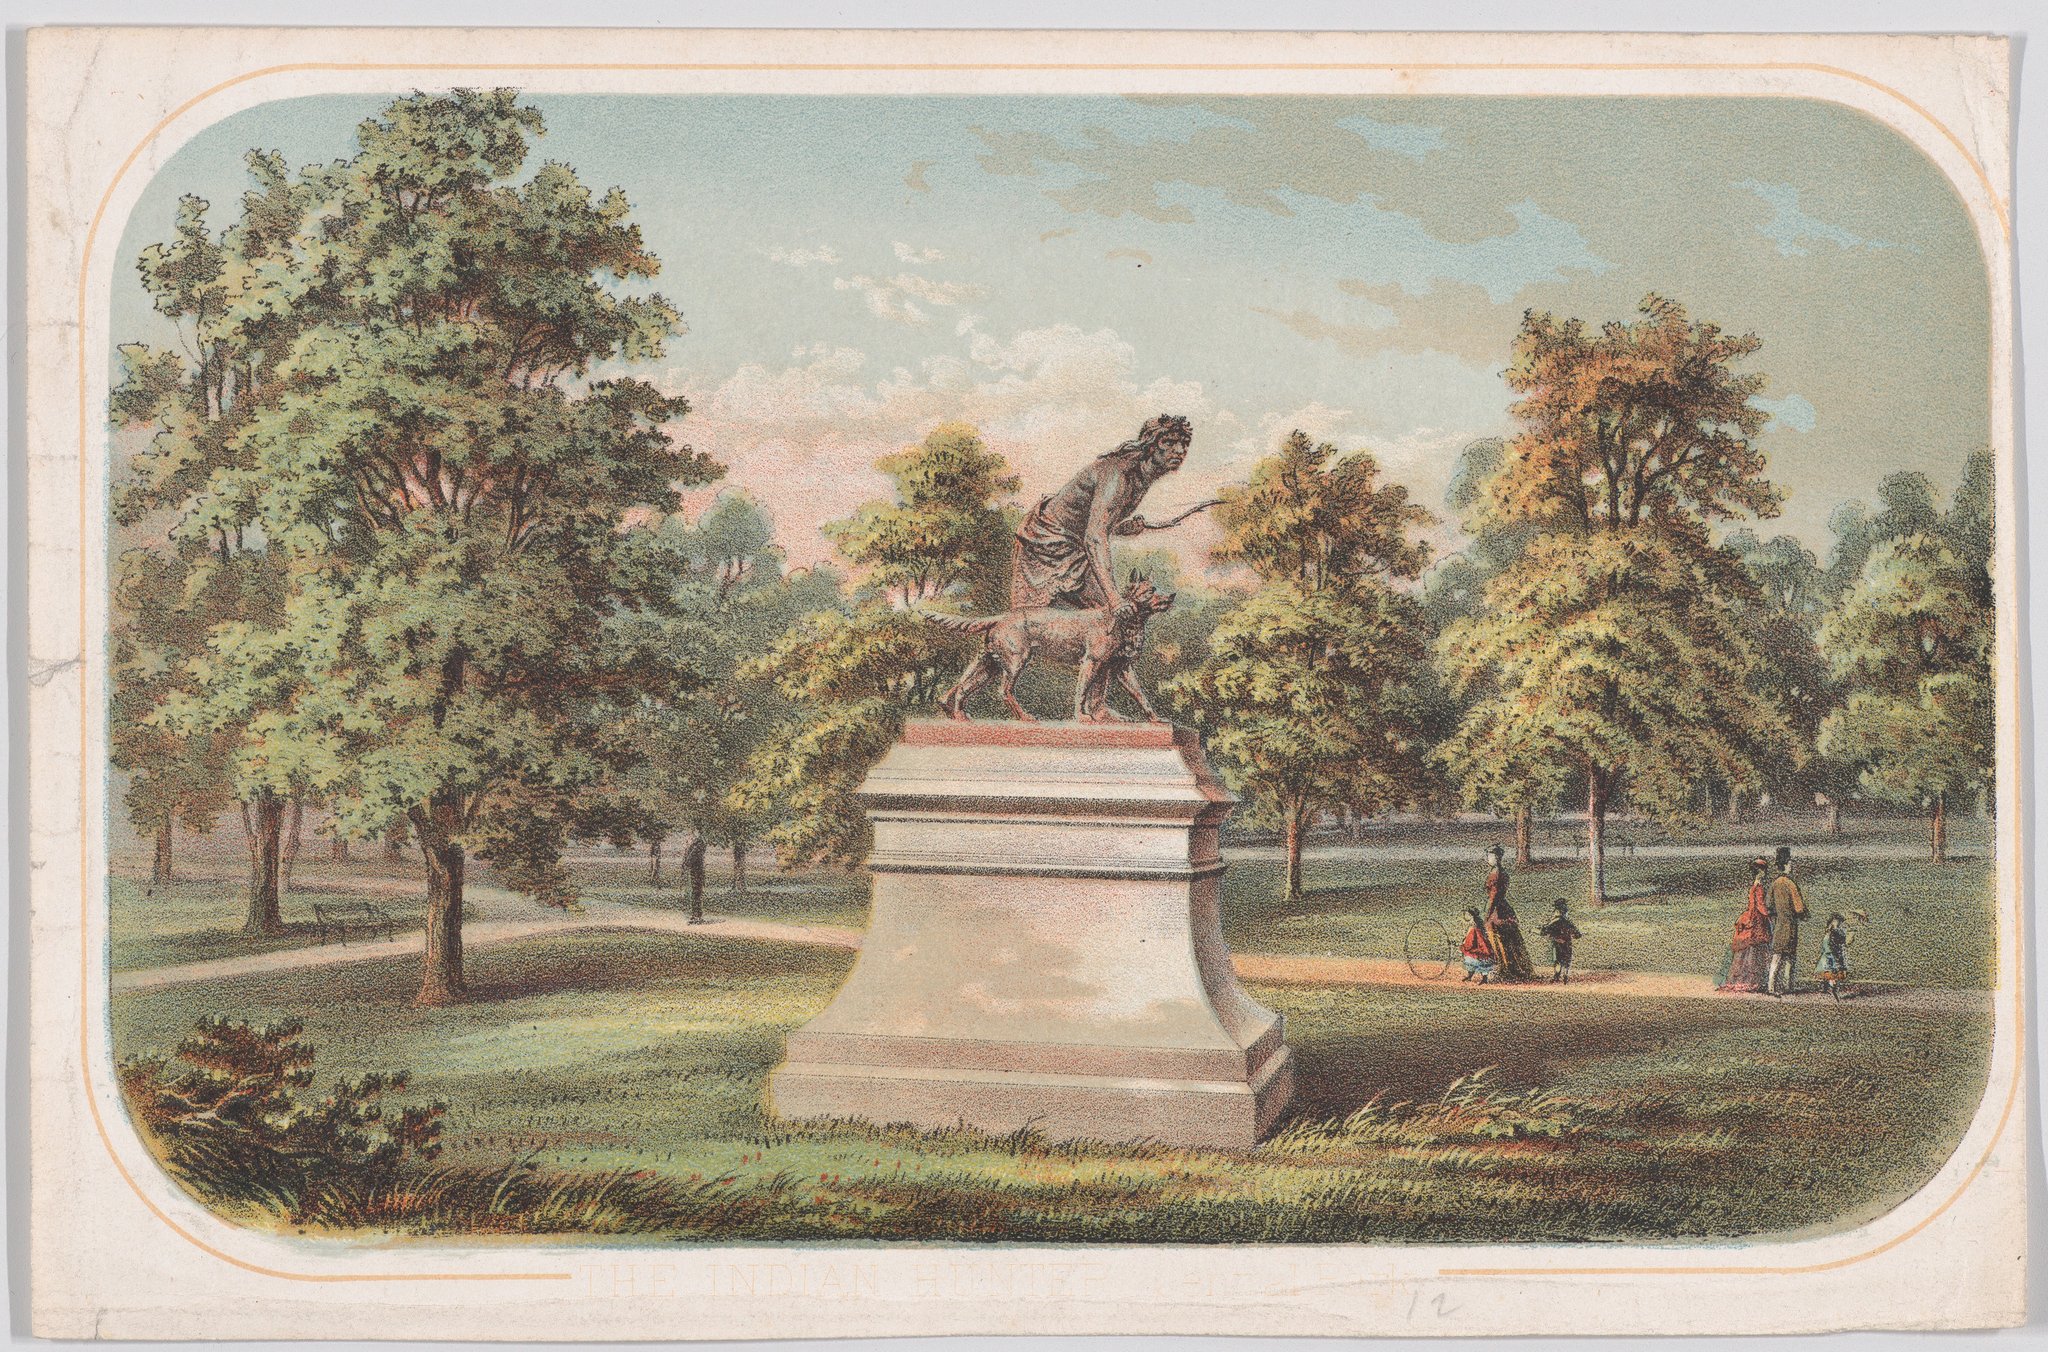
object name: print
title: Central Park, Statue of the Indian Hunter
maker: anonymous, american, 19th century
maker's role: artist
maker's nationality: american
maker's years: 1800-1900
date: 1869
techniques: hand coloring, lithograph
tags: sculpture,parks,hunting,dogs